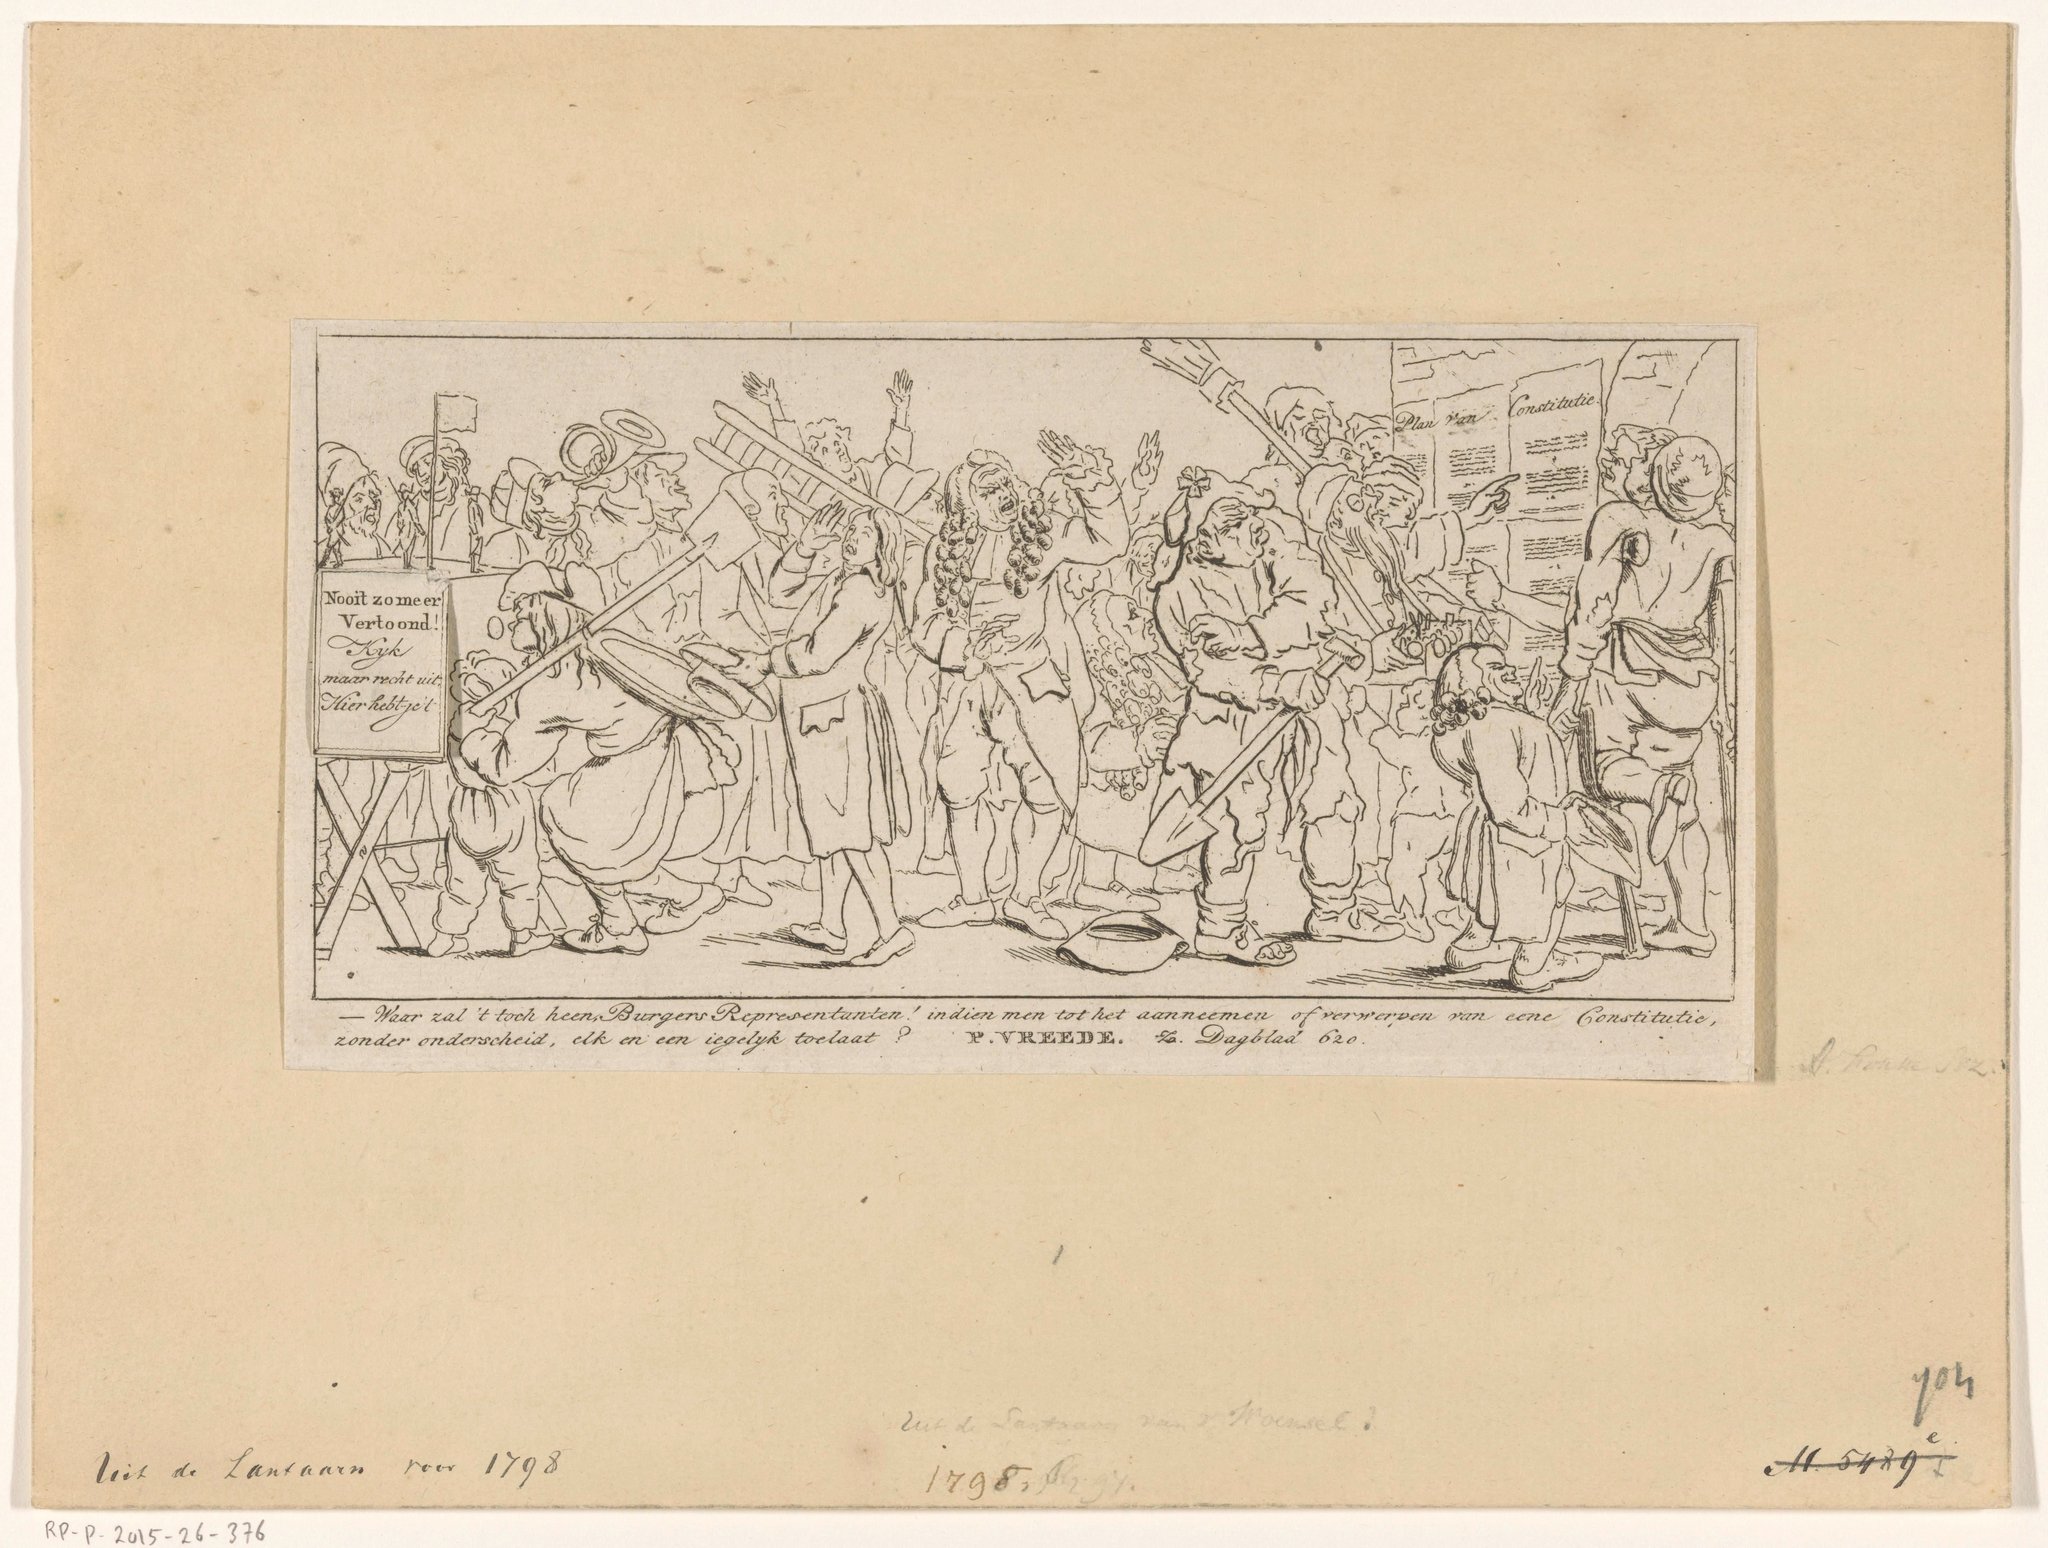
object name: print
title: Spotprent op verwerping van het Plan van Constitutie, 1797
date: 1797-1798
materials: paper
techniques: etching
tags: other kinds of amusement, political caricatures and satires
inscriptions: collector's mark: Lugt 4779, collector's mark: ‘S.J. Robitsch 's-Gravenhage’, collector's mark: Lugt 2228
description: Spotprent waarin het volk het verwerpen van het Plan van Constitutie op 8 augustus 1797 bespot. Op een muur is het Plan geplakt dat gelezen en beoordeeld wordt het gewone volk en de burgerij. Links een kijkdoos waarbij een flap papier dat opgetild kan worden en waaronder te lezen staat: 189e Plan v. Constitutie, Anno 1961. Met tweeregelig onderschrift. Illustratie in Pieter van Woensels almanak 'De Lantaarn voor 1798'.